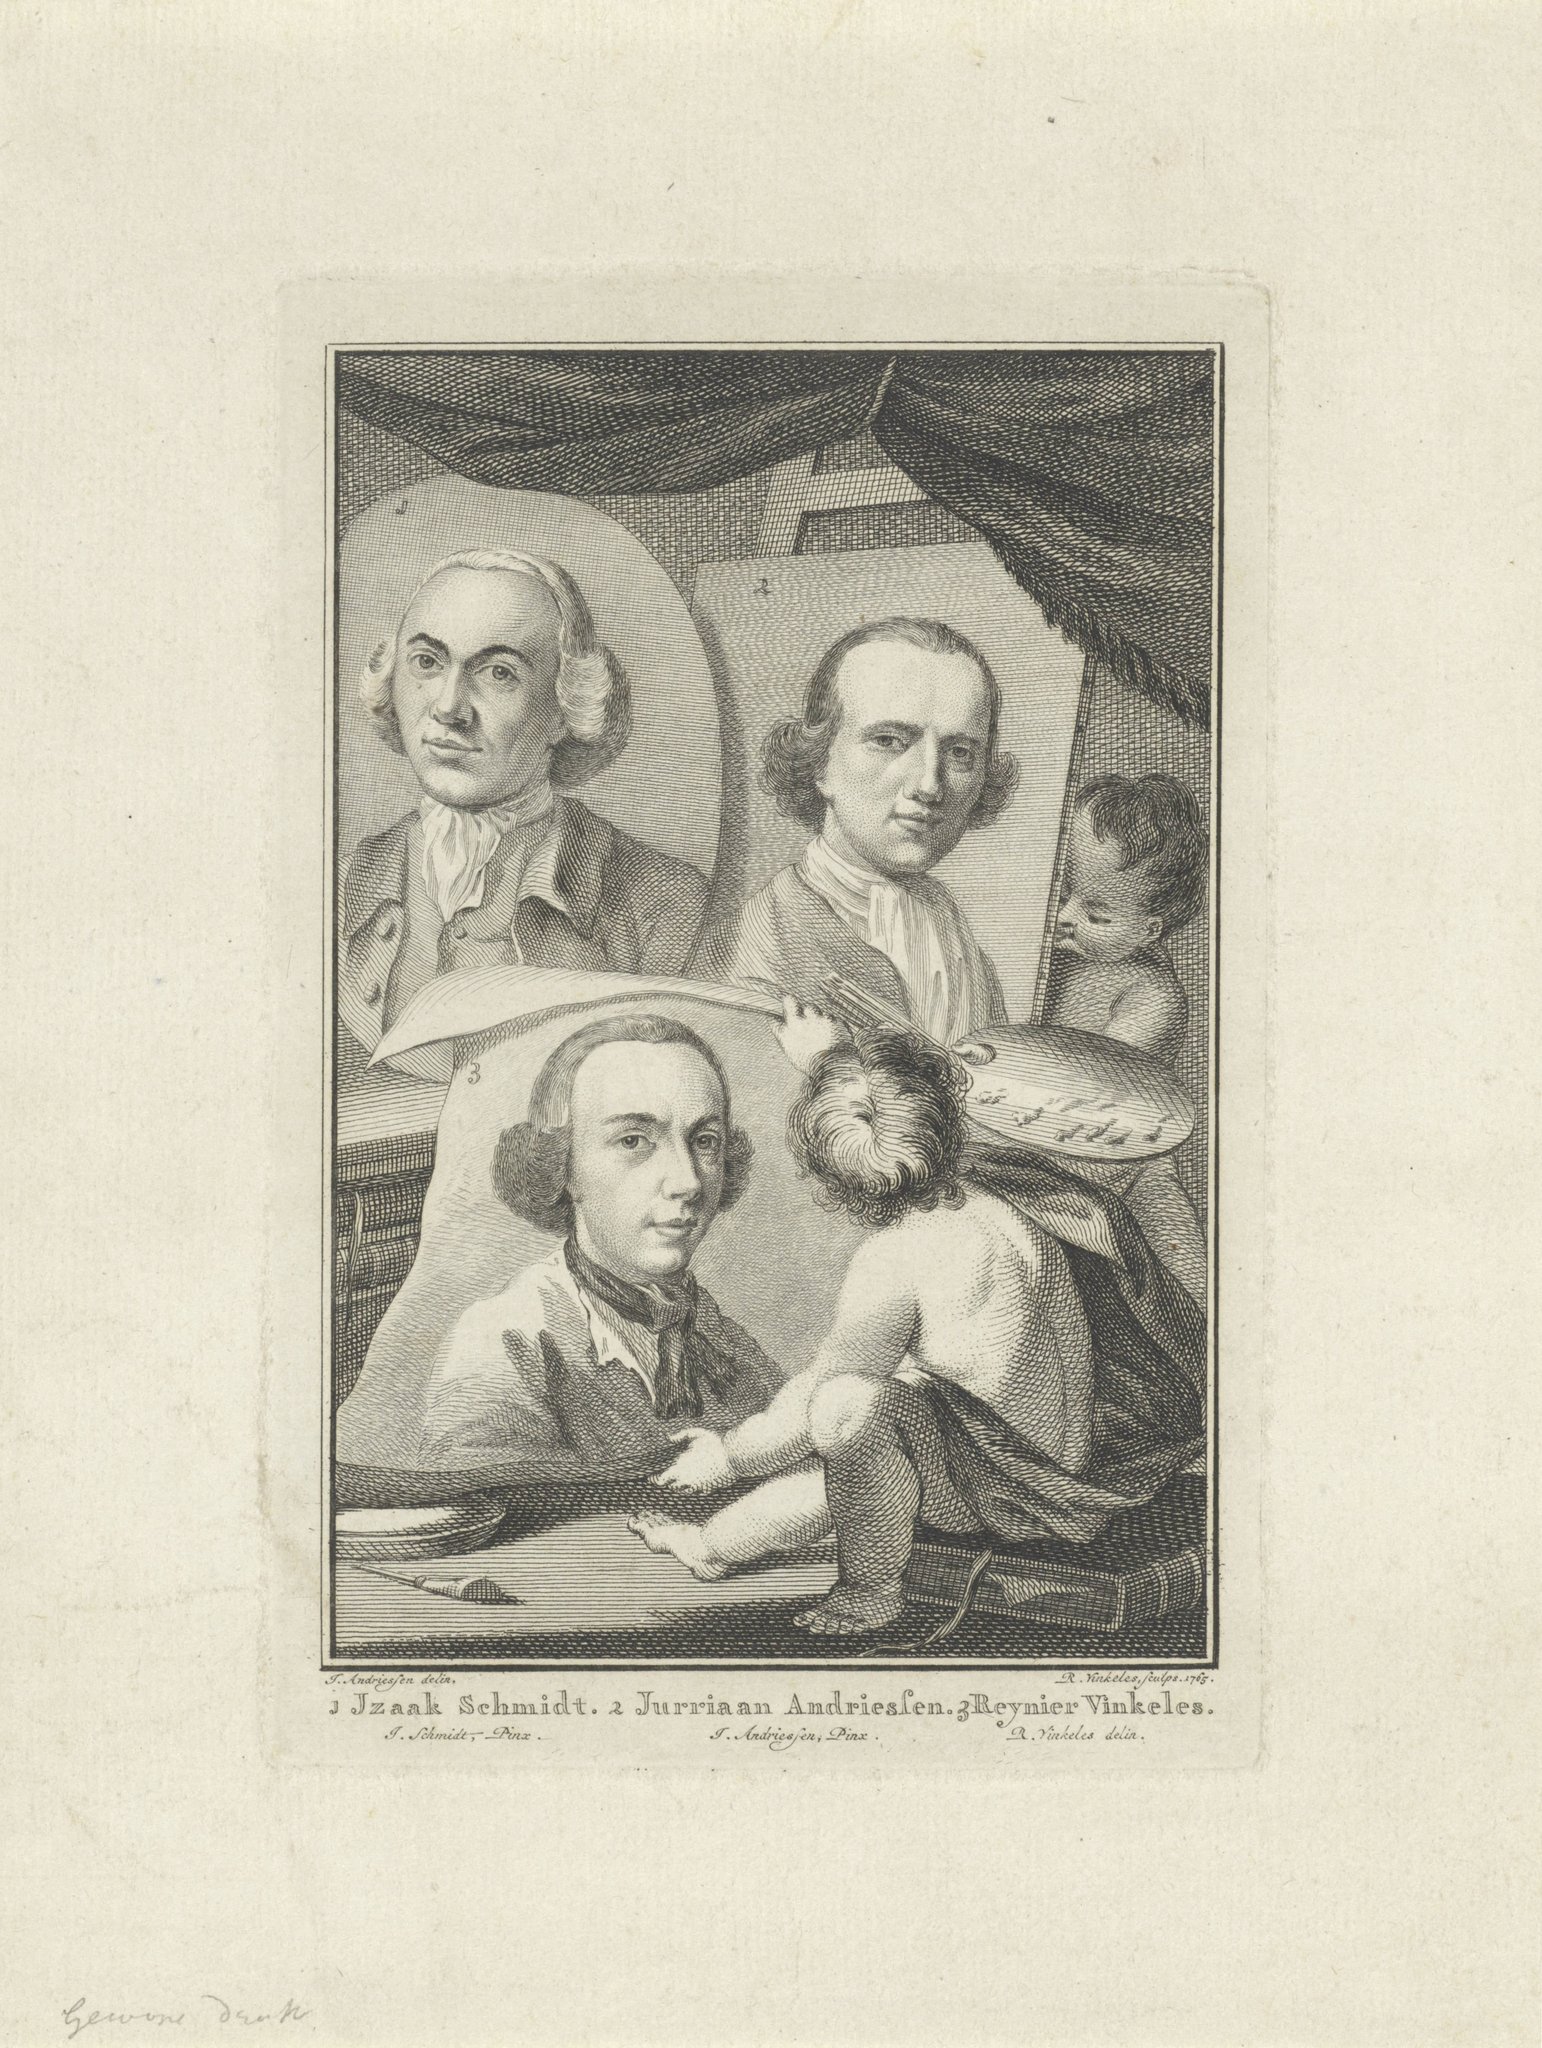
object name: print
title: Portretten van Izaak Schmidt, Jurriaan Andriessen en Reinier Vinkeles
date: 1765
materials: paper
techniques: engraving, etching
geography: amsterdam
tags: painter, jurriaan andriessen, amsterdam, print maker, izaak schmidt, reinier vinkeles (i), palette, cupids: 'amores', 'amoretti', 'putti'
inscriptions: signature and date: ‘r.o.: R. Vinkeles sculps. 1765 l.o.: J. Andriessen delin.’, collector's mark: Lugt 2228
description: Twee putti bij de portretten van de kunstenaars Izaak Schmidt, Jurriaan Andriessen en Reinier Vinkeles.